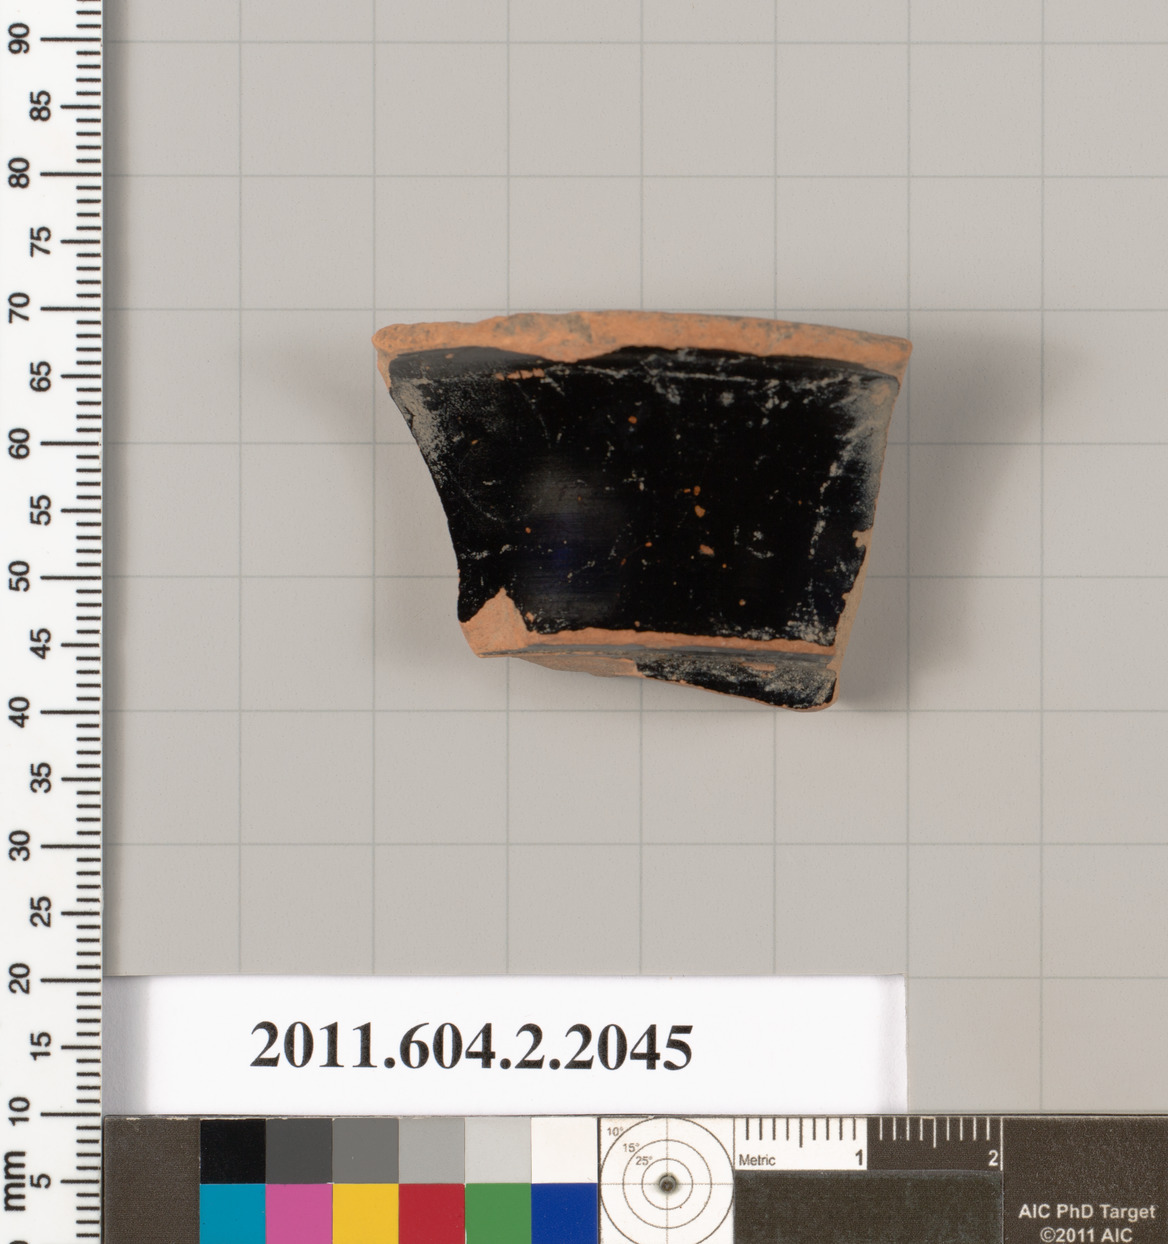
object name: kalathos fragment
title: Terracotta fragment of a kalathos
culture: greek, attic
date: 520-500 BCE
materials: terracotta